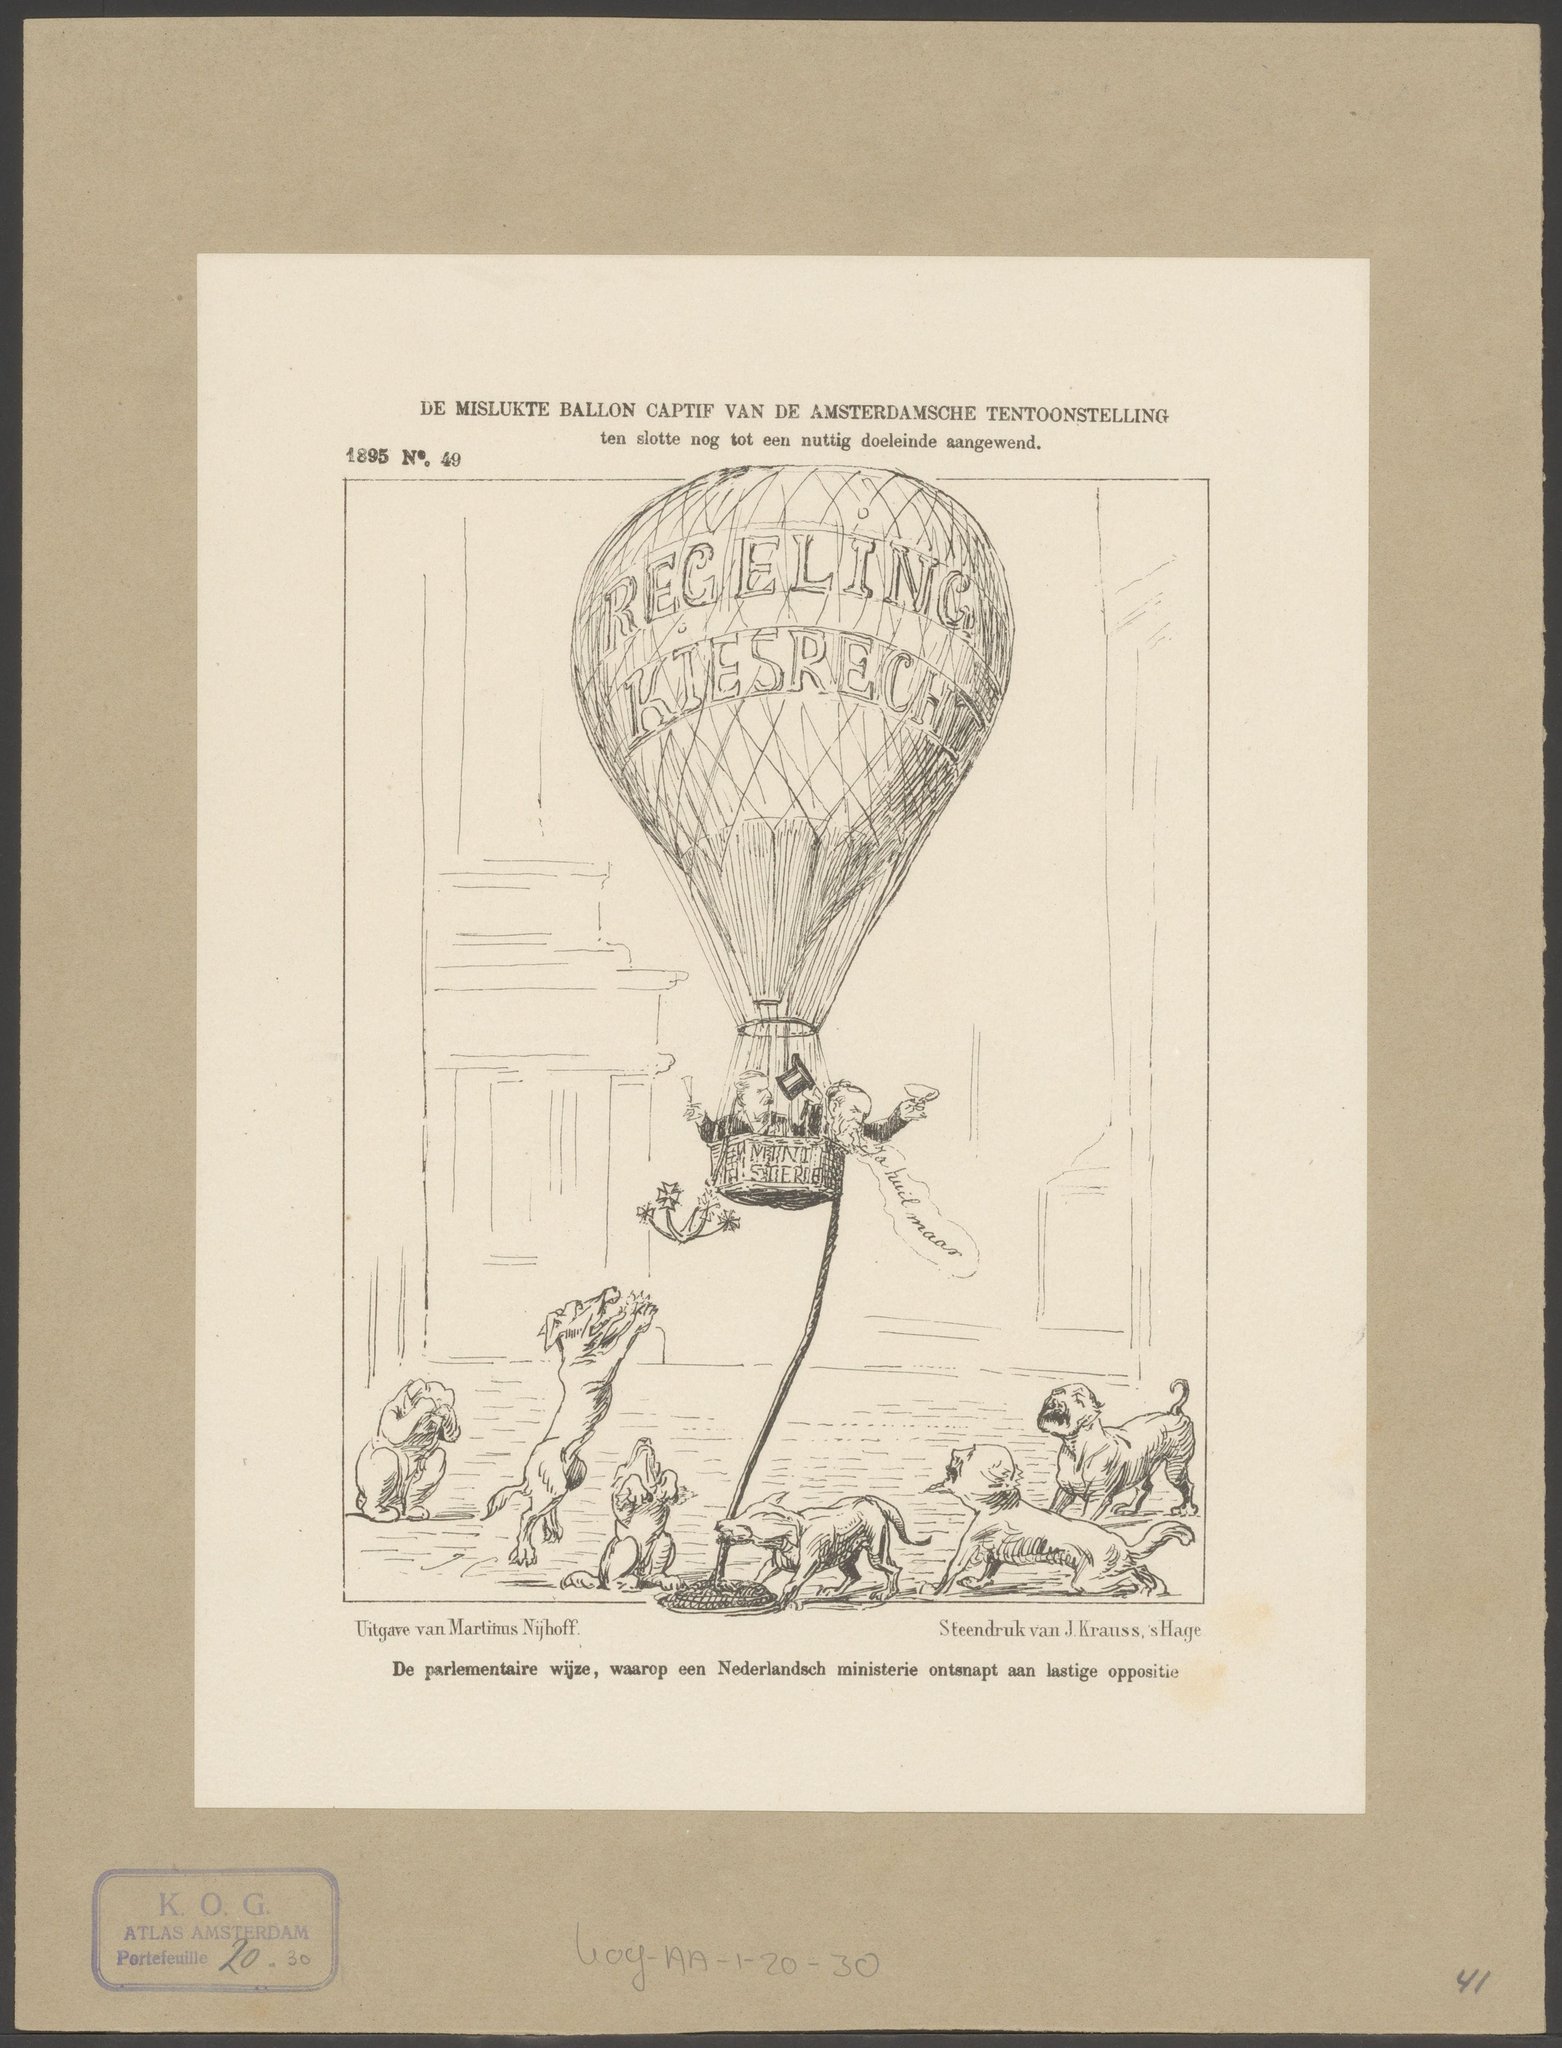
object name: cartoon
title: Twee mannen ontsnappen in een luchtballon aan zes honden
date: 1895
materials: paper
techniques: letterpress printing, lithograph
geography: netherlands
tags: balloon (aviation), political caricatures and satires, dog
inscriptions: monogram: ‘JC’, collector's mark: Lugt 1641b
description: Prent waarschijnlijk uit: De Nederlandsche Spectator (1895), nr. 49, 7 december 1895.